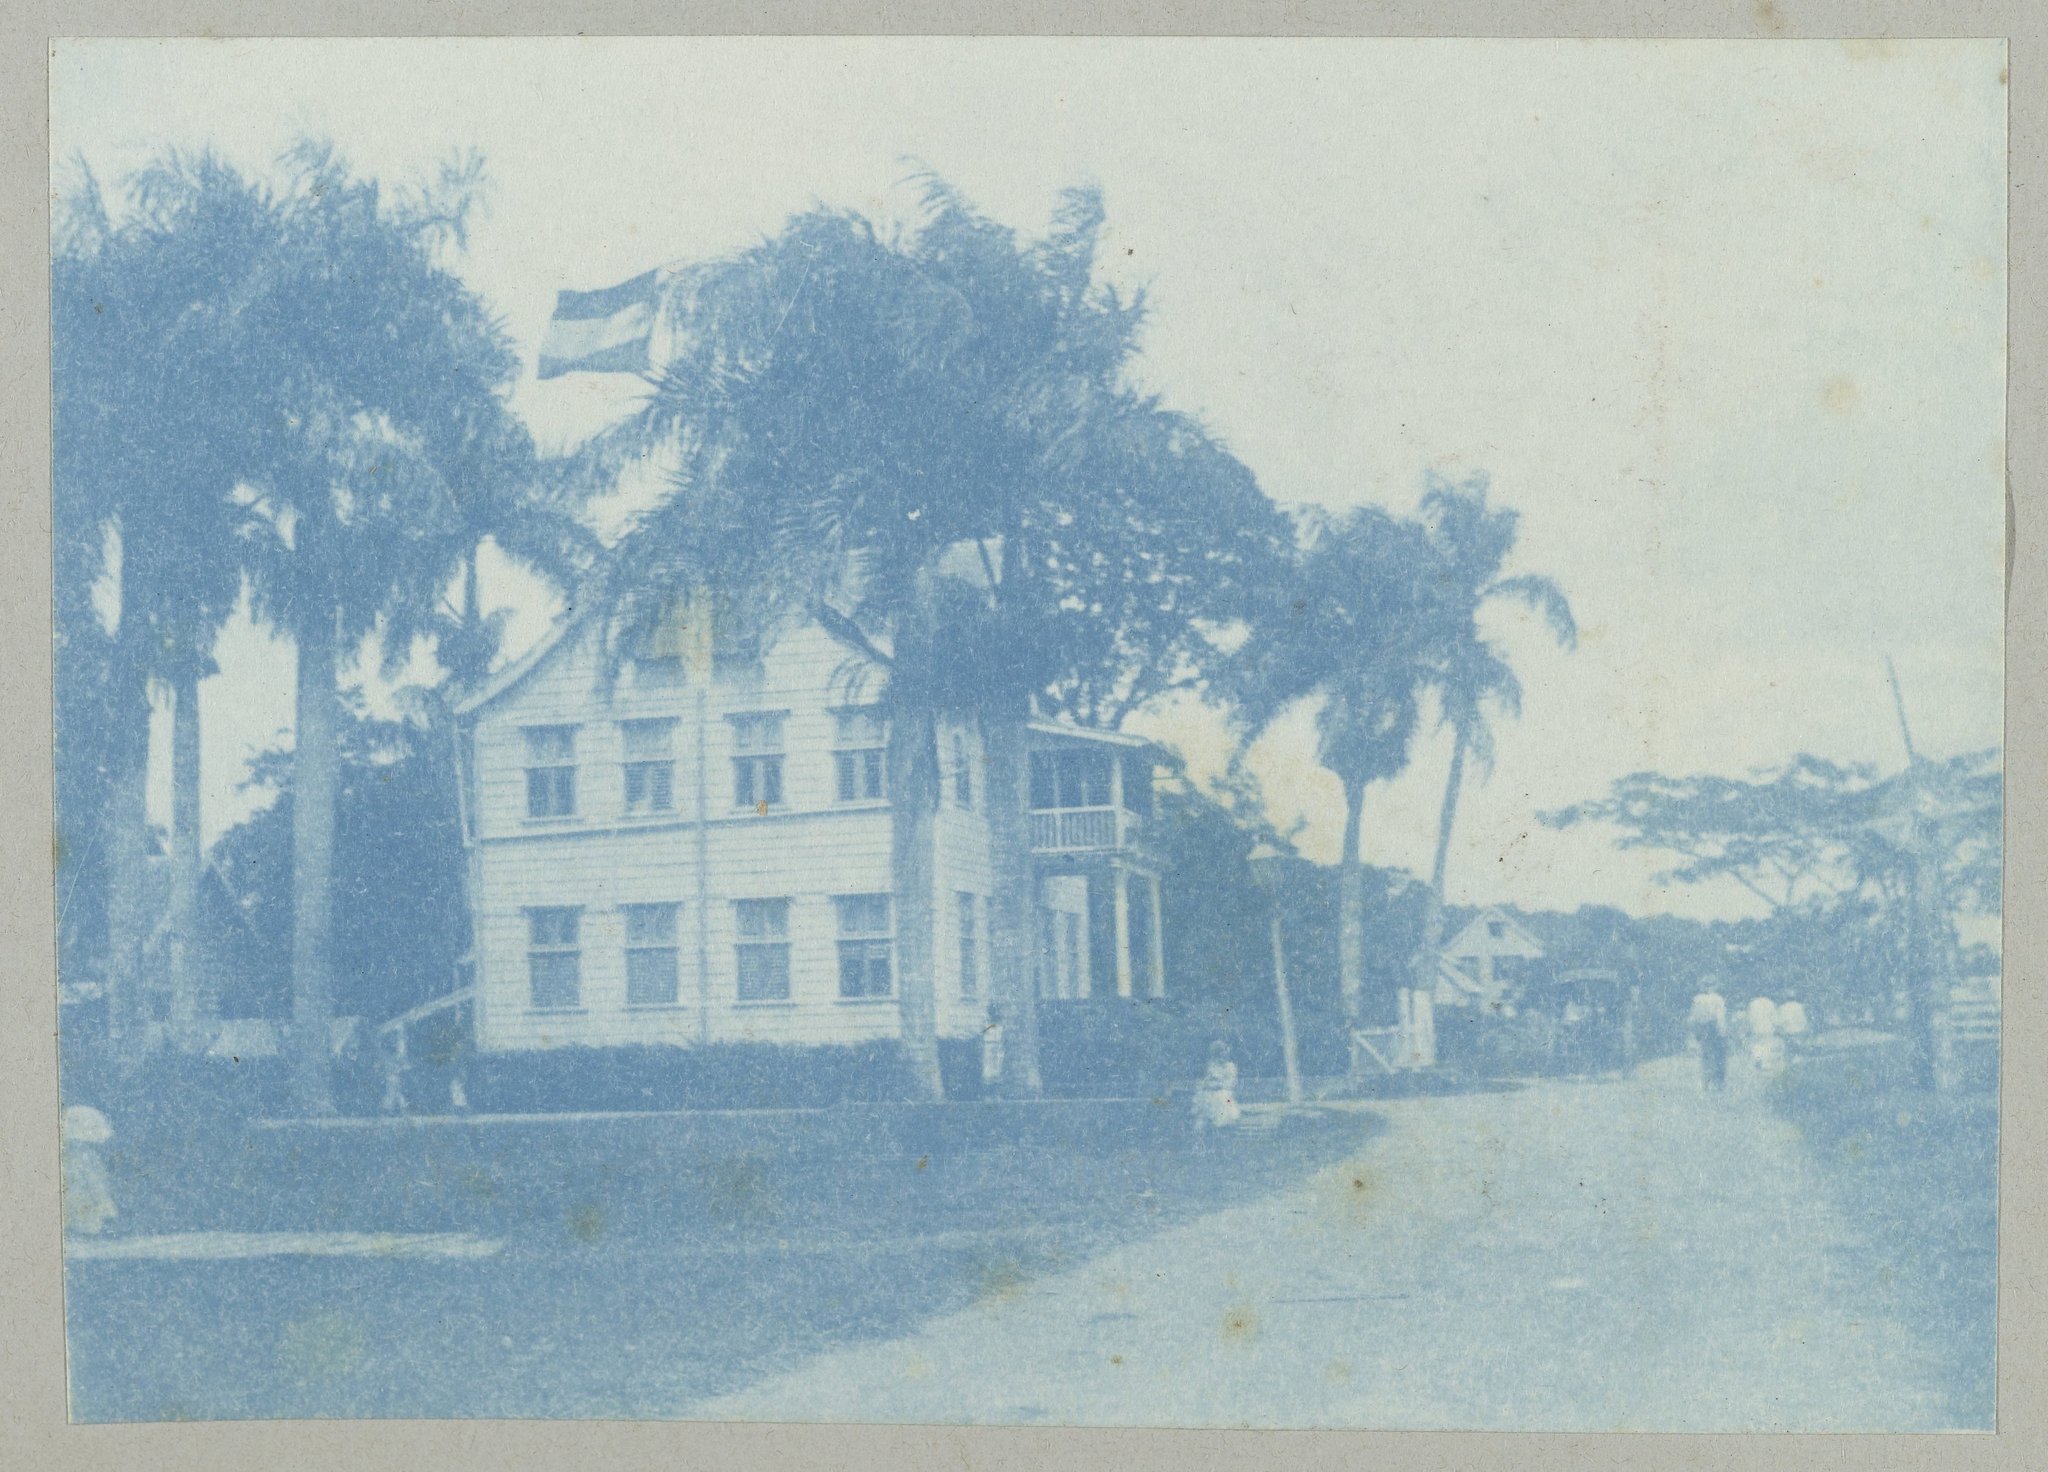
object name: photograph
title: Commissariaat in de Combé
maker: hendrik doijer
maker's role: engineer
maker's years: 1863-1925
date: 1903-1910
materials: photographic support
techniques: cyanotype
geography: suriname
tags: suriname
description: Gebouw van de commissariaat in de Combé in Paramaribo. Onderdeel van het fotoalbum Souvenir de Voyage (deel 1), over het leven van de familie Doijer in en rond de plantage Ma Retraite in Suriname in de jaren 1903-1910.